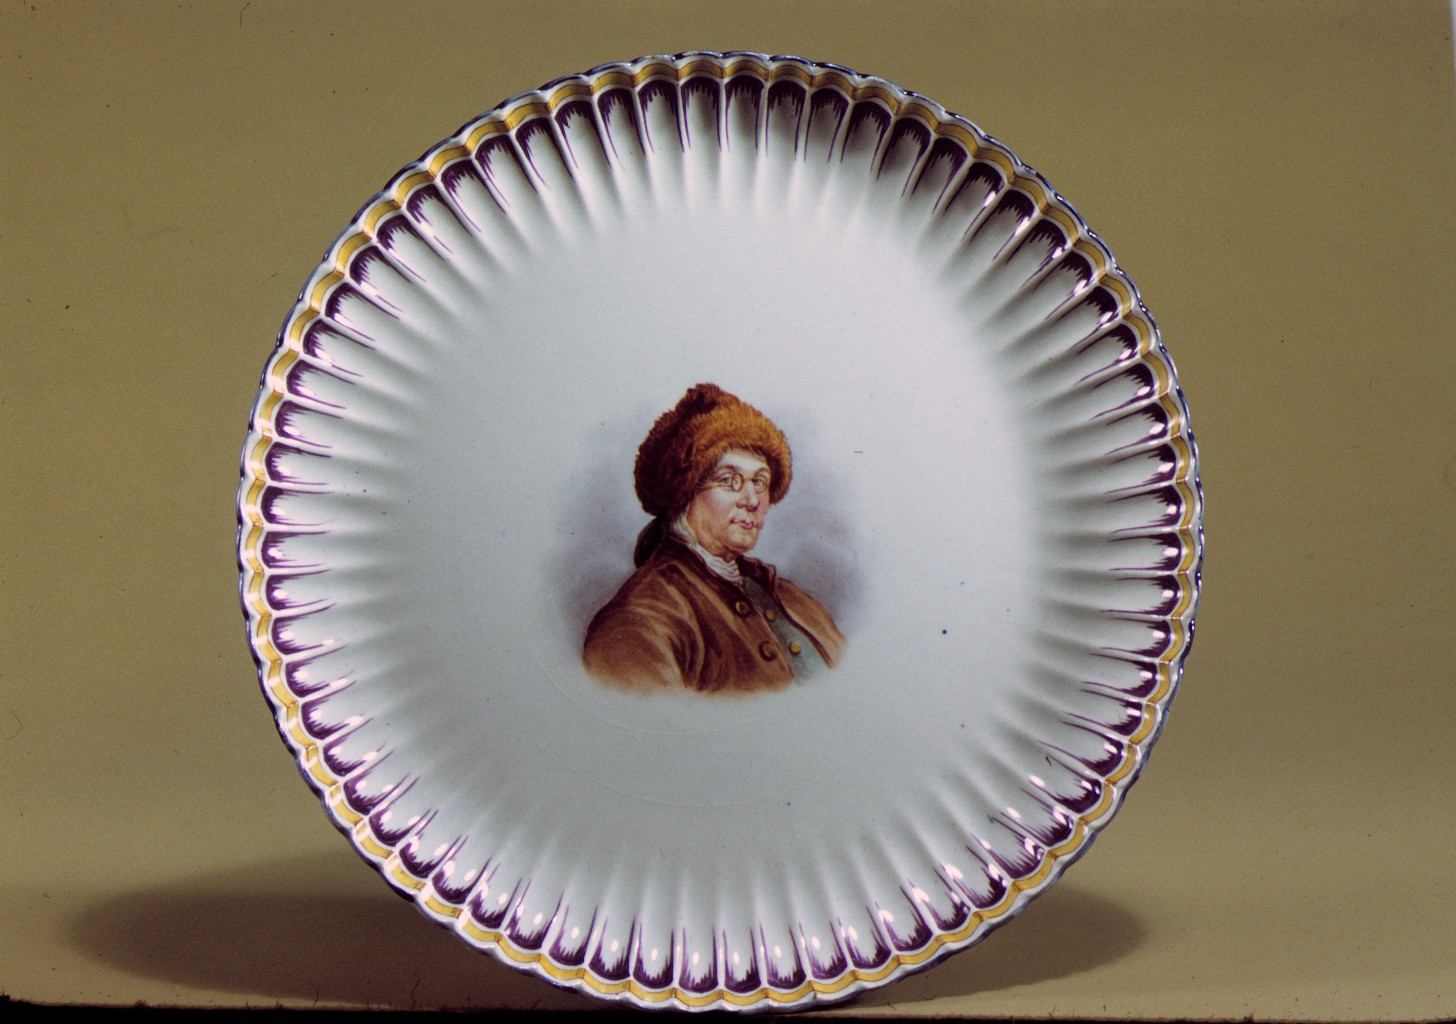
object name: plate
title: Benjamin Franklin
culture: french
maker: pierrette caudelot perrin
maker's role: maker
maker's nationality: french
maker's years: 1740-1793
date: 1770-1800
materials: faience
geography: france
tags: benjamin franklin,portraits